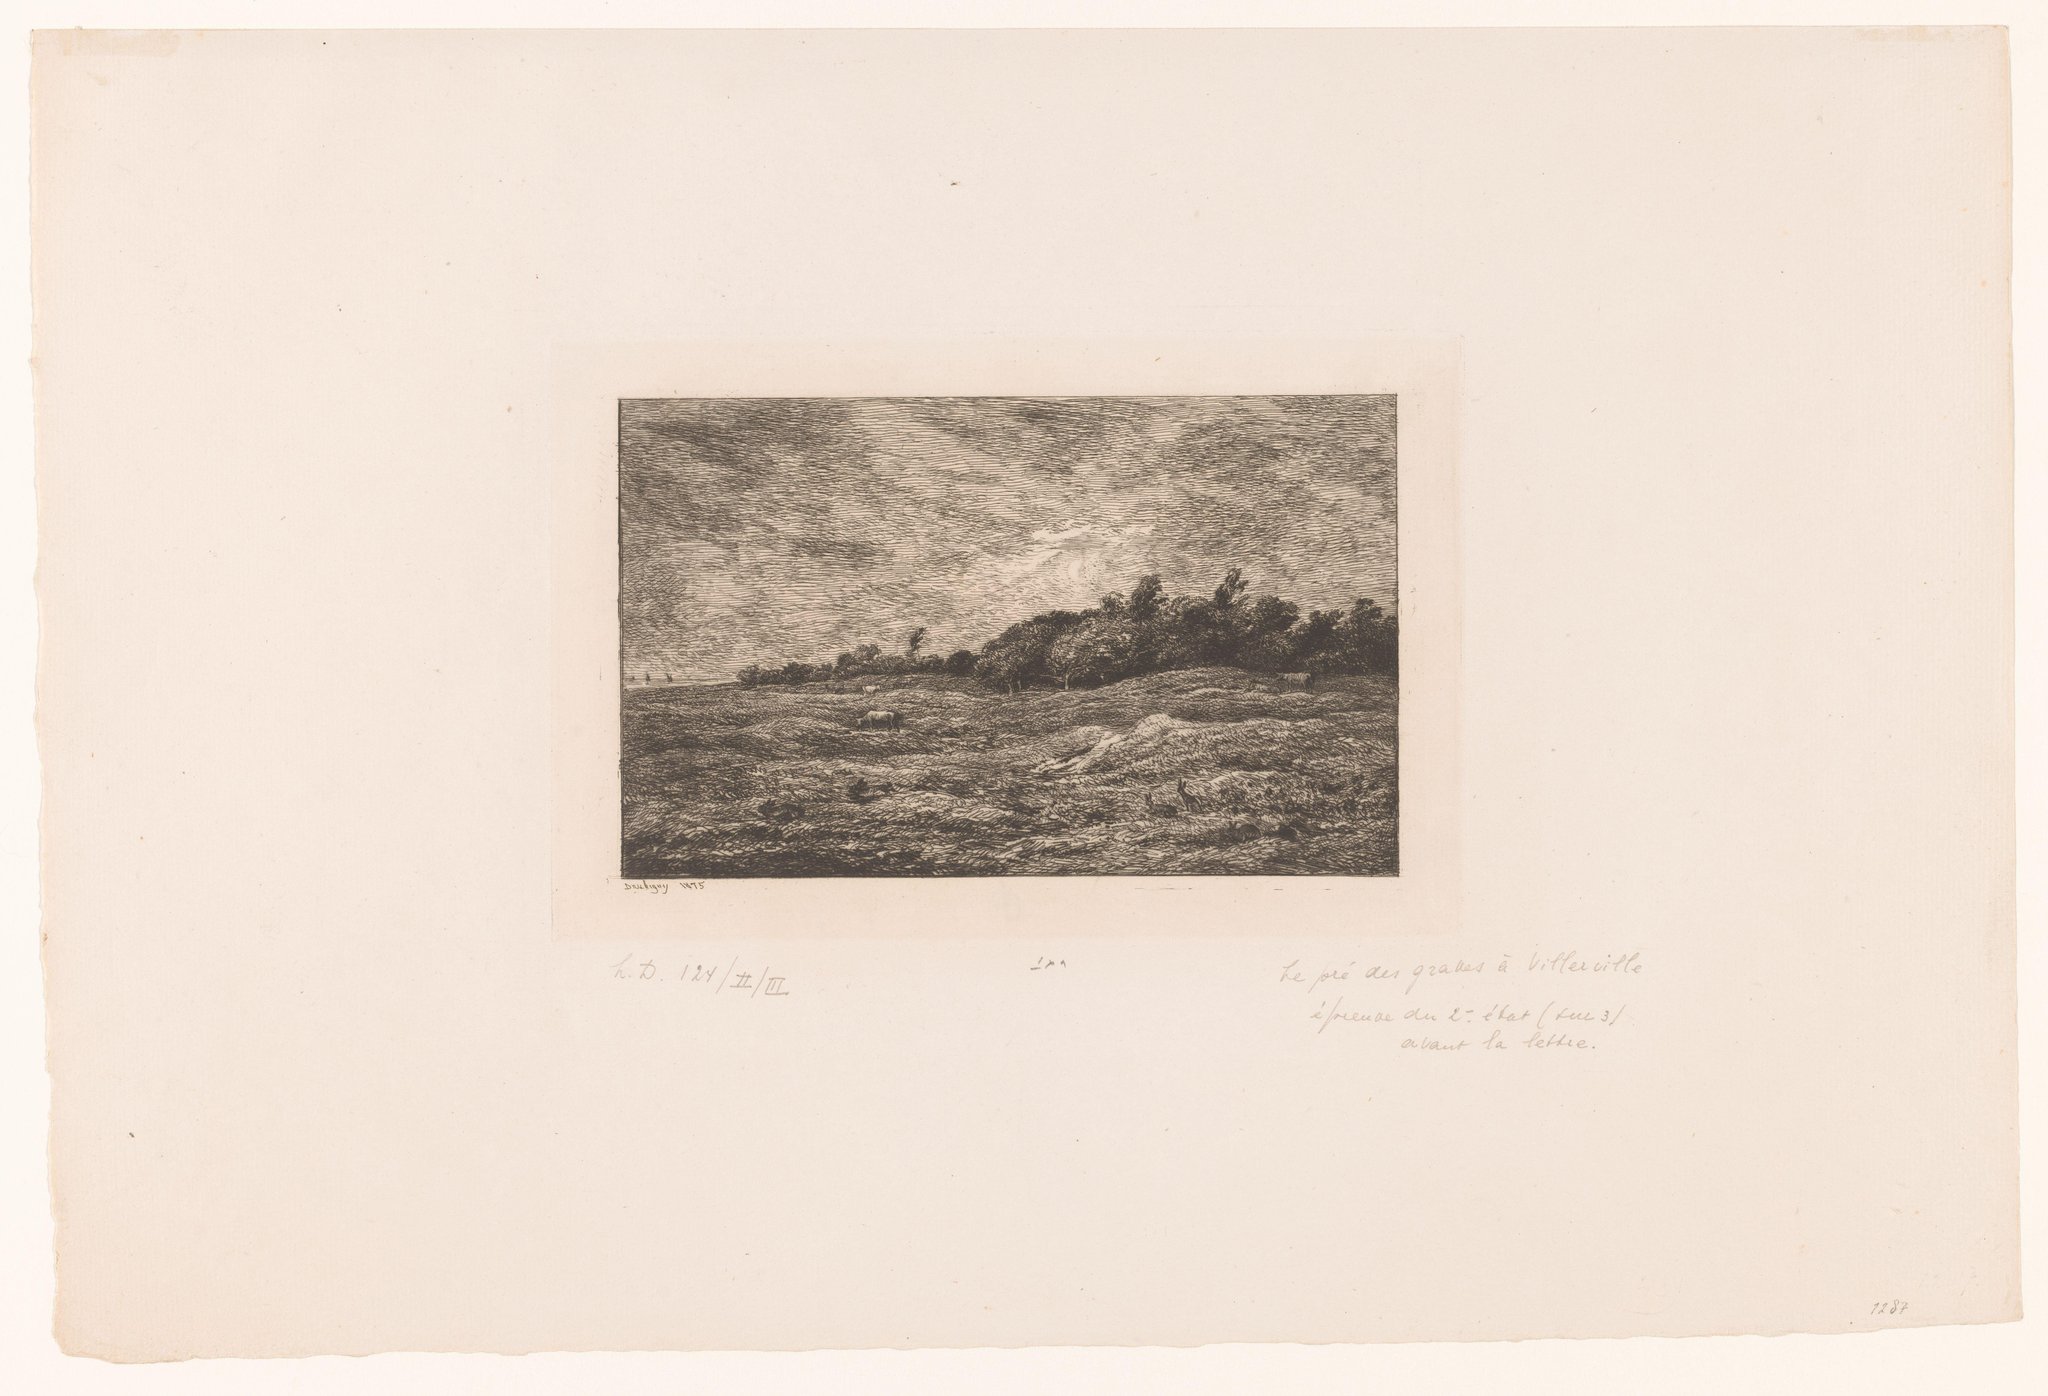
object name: print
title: Le pré des Graves à Villerville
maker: charles-françois daubigny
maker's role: draughtsman, painter, print maker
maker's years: 1817-1878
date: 1875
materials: paper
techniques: drypoint, etching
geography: france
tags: landscapes, herd, flock, rodents: rabbit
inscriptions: watermark, collector's mark: Lugt 4731, collector's mark: Lugt 2228